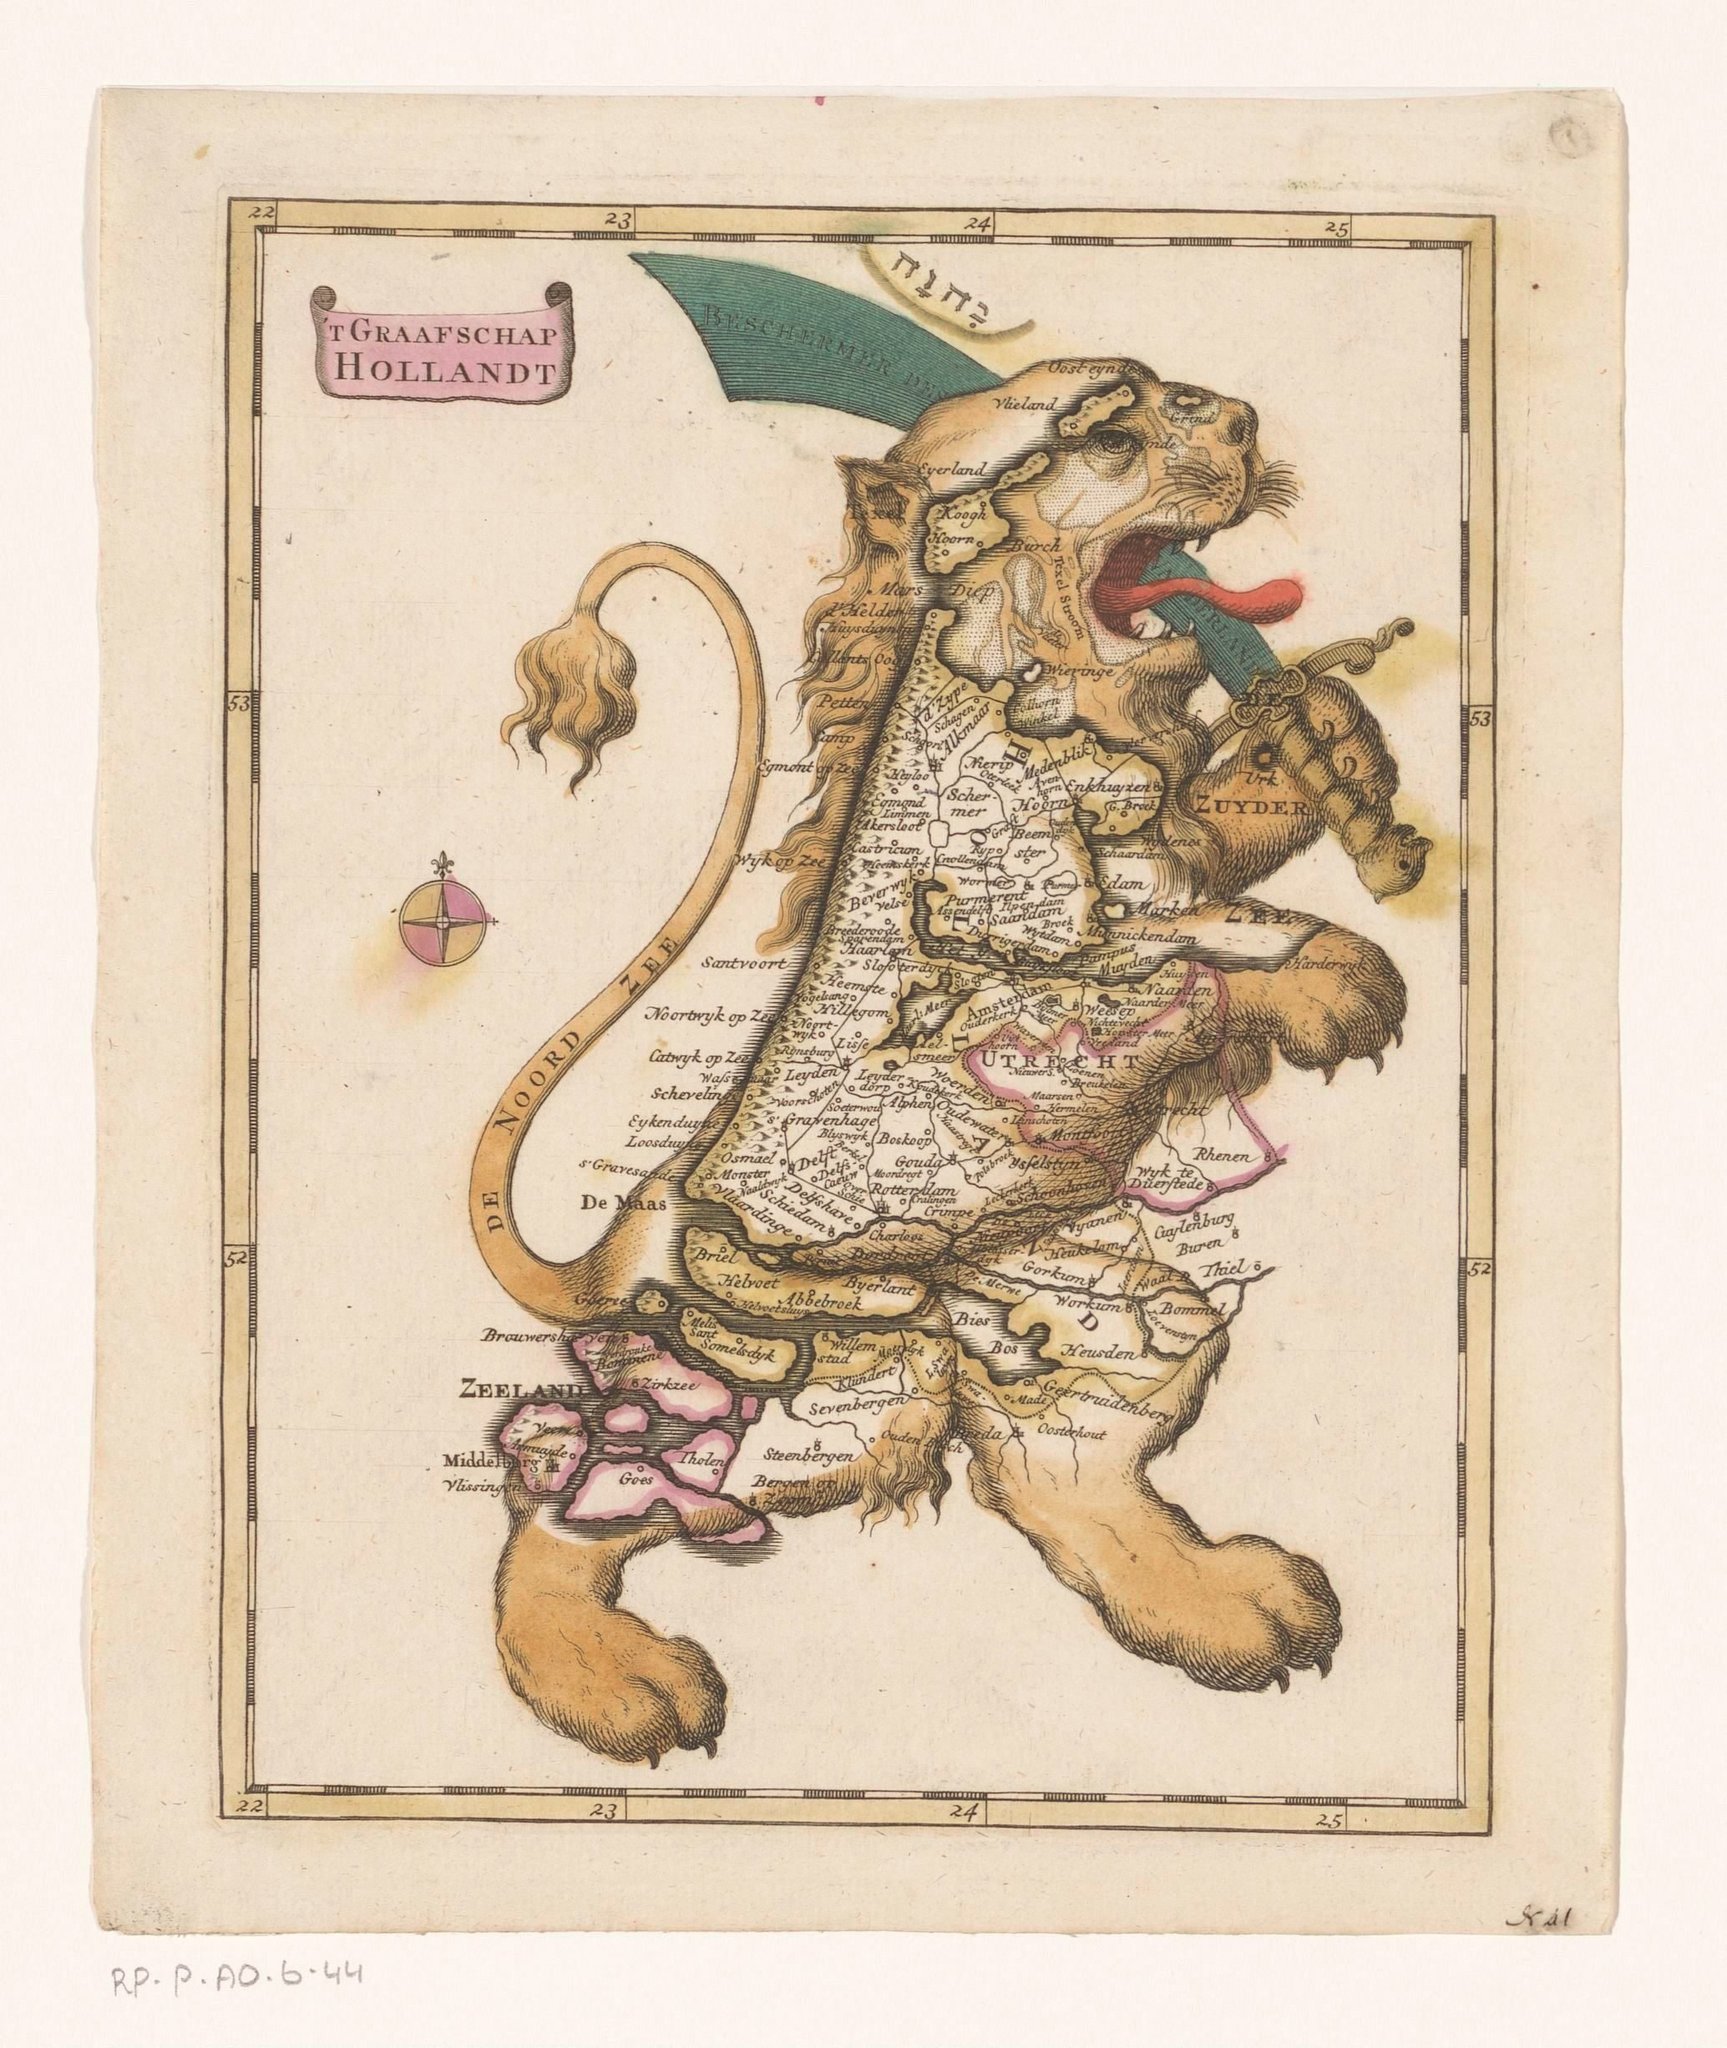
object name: print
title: Kaart van het graafschap Holland in de vorm van de Nederlandse Leeuw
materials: paper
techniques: engraving, hand coloring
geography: amsterdam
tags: maps of separate countries or regions, holland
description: Prent ook gebruikt in: Gebruyck der Cooplieden Reizigers en Officieren ofte Memorie Boekje Behelsende twee Steedewyzers (…). Amsterdam, Pieter Schenk (II), 1748. Later opnieuw gebruikt in: Gebruyck der Cooplieden Reizigers en Officieren ofte Memorie Boekje Behelsende twee Steedewyzers (…). Amsterdam, Covens, Mortier en Zoon, 1840.